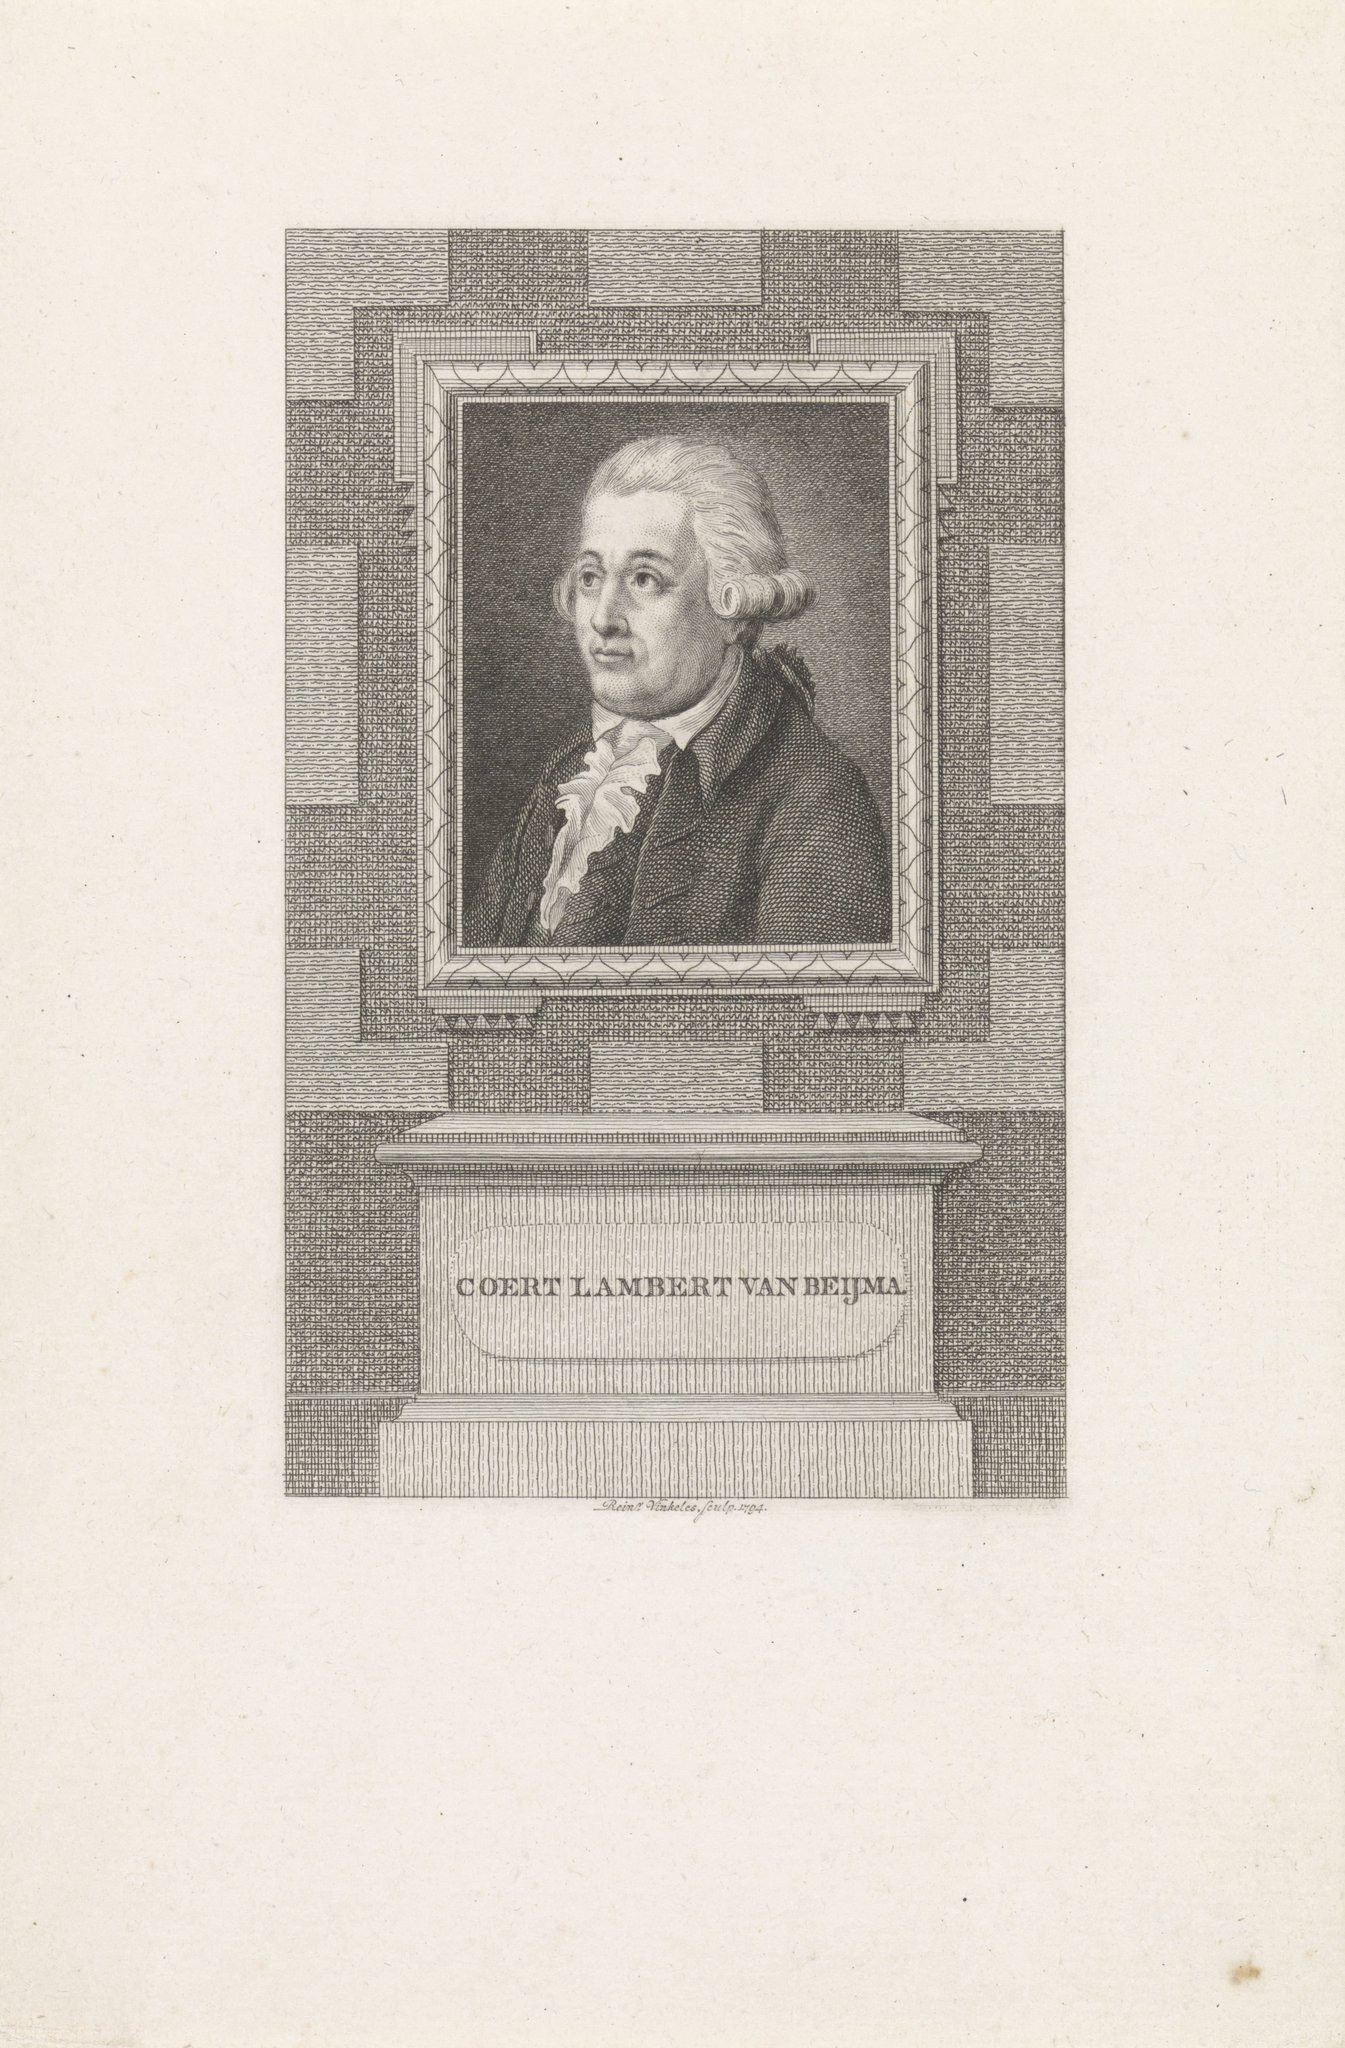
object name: print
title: Portret van Coert Lambertus van Beyma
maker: reinier vinkeles (i)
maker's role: draughtsman, print maker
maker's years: 1741-1816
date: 1794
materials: paper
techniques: engraving, etching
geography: amsterdam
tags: coert lambertus van beyma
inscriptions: collector's mark: Lugt 2228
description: Prent ook gebruikt als boekillustratie in: Wagenaar, Jan. Vaderlandsche historie, (...) ten vervolge van Wagenaars Vaderlandsche historie. Dl. 1-43. Amsterdam: Johannes Allart, 1786-1809. Dertiende deel, 1794.